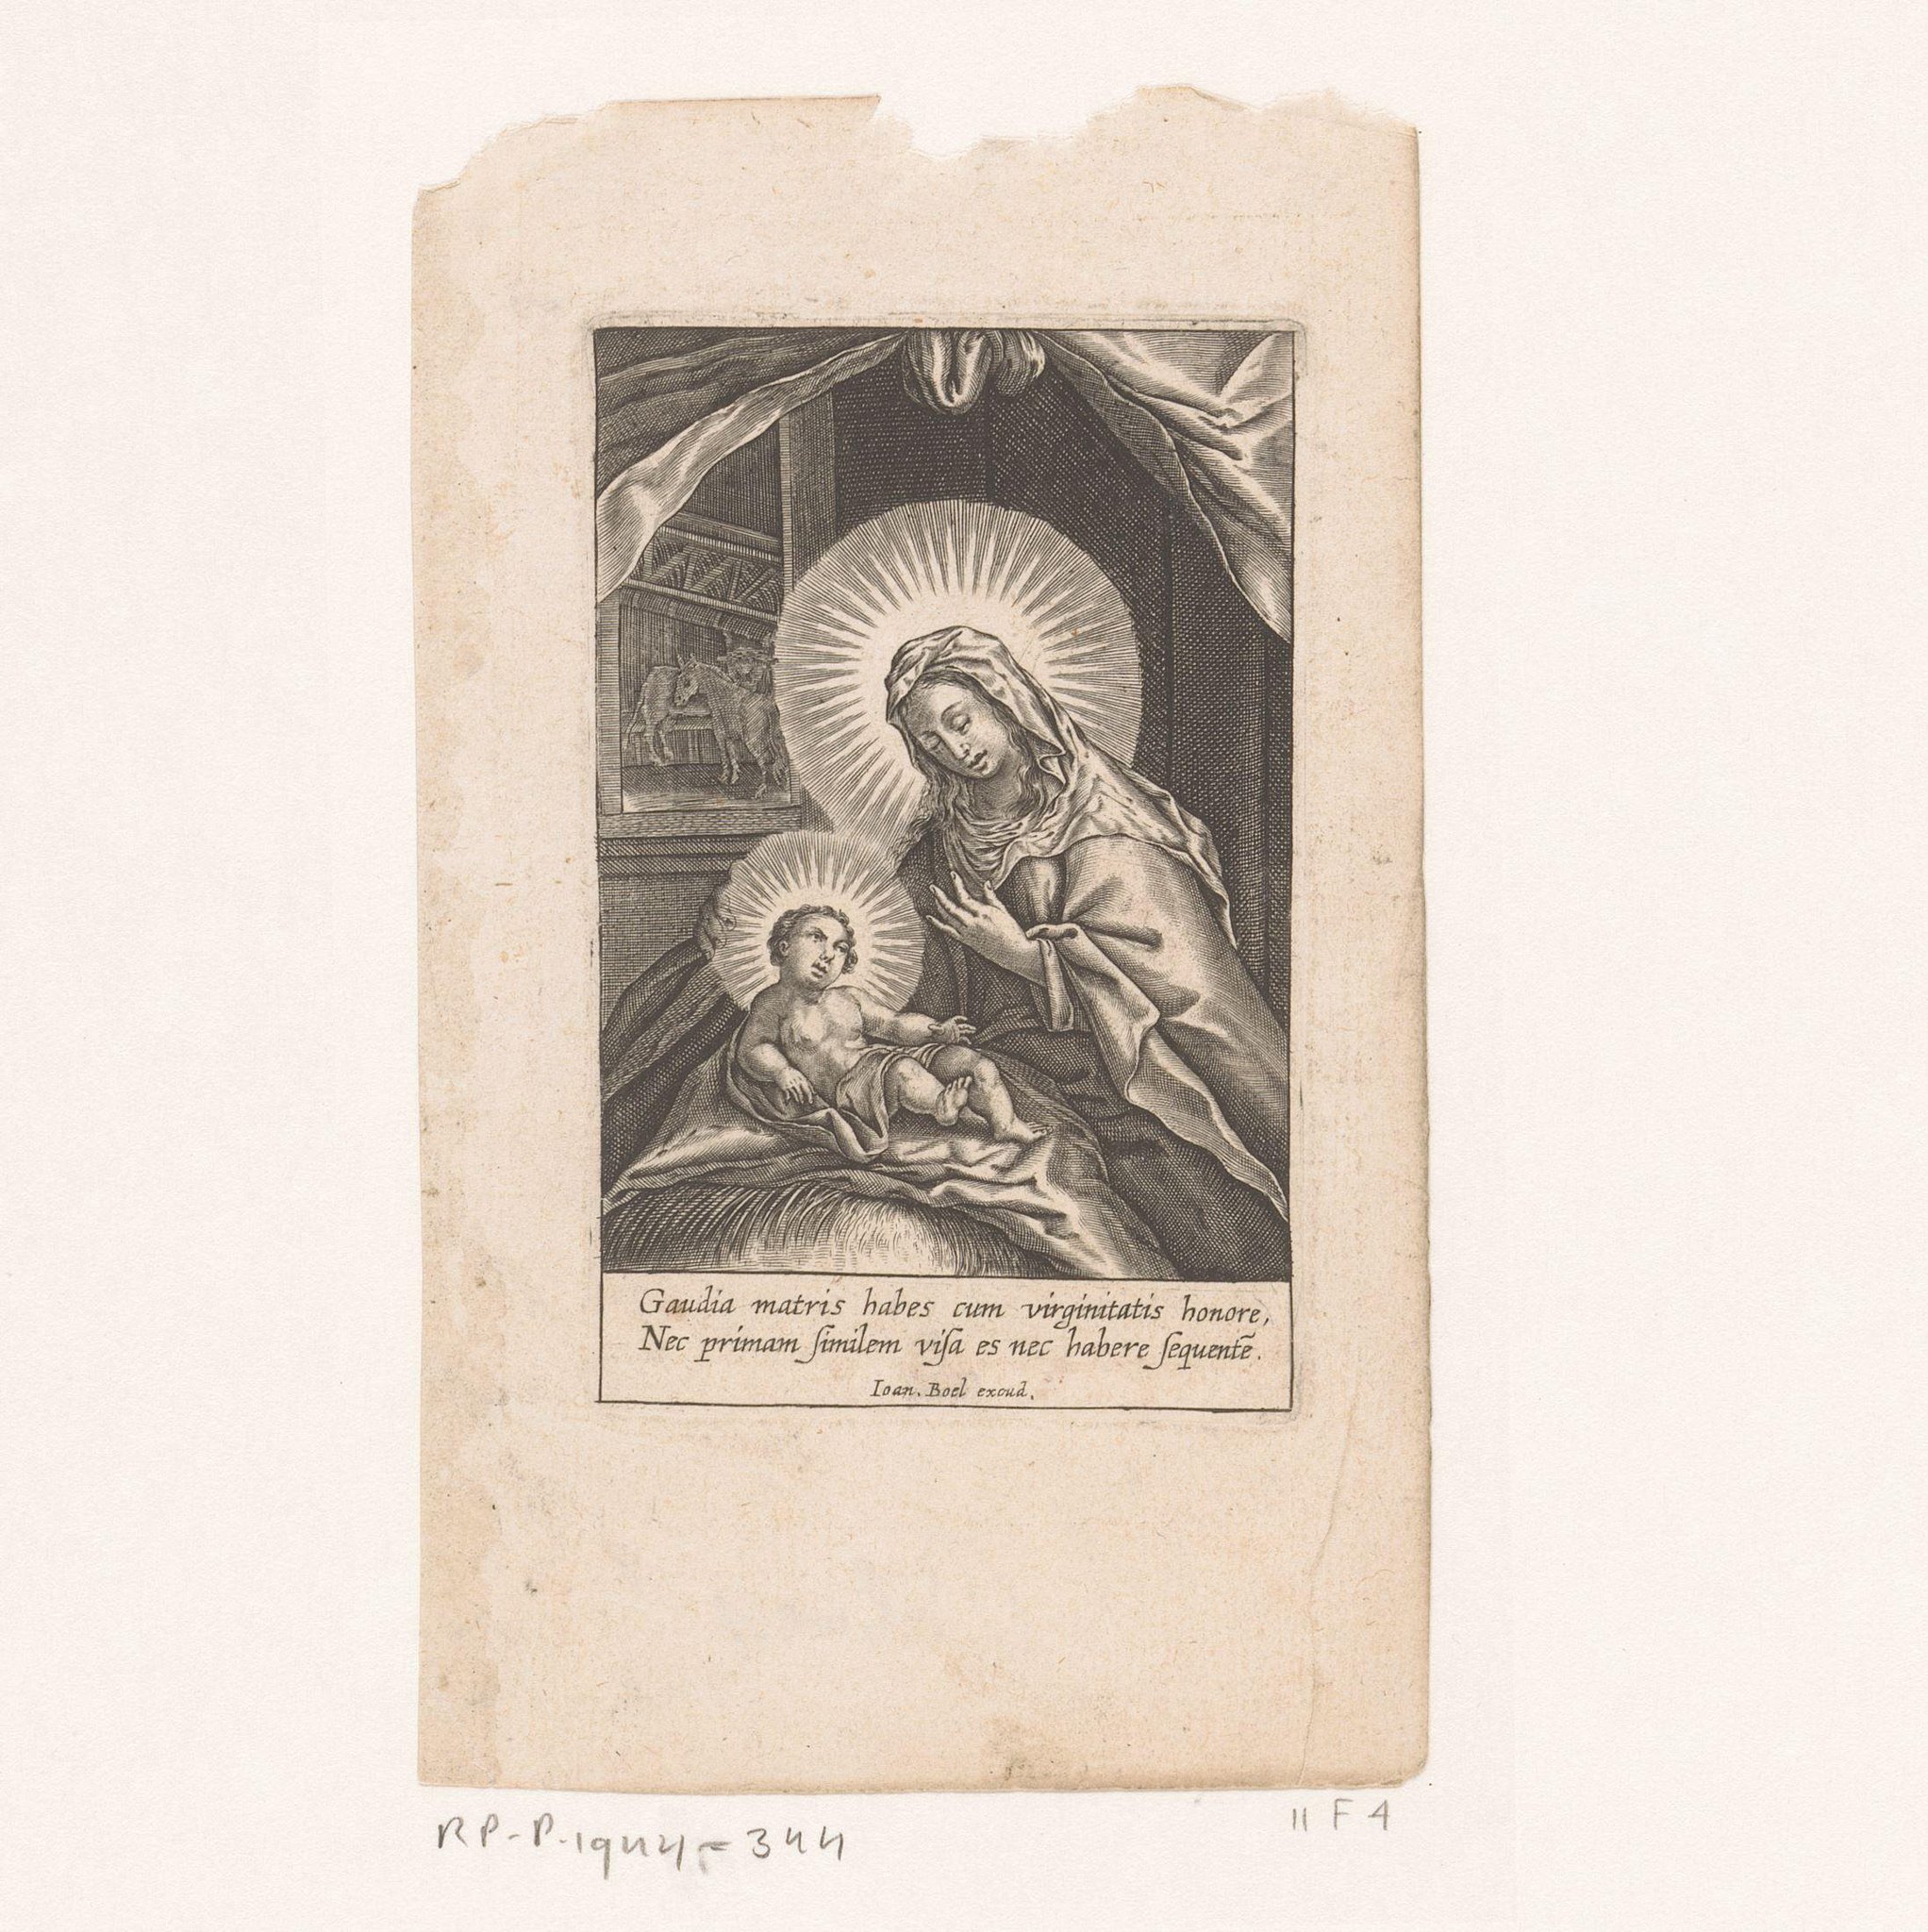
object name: print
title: Maria met kind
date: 1602-1640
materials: paper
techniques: engraving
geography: antwerp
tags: madonna: i.e. mary with the christ-child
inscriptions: collector's mark: Lugt 2228, collector's mark: Lugt 2227